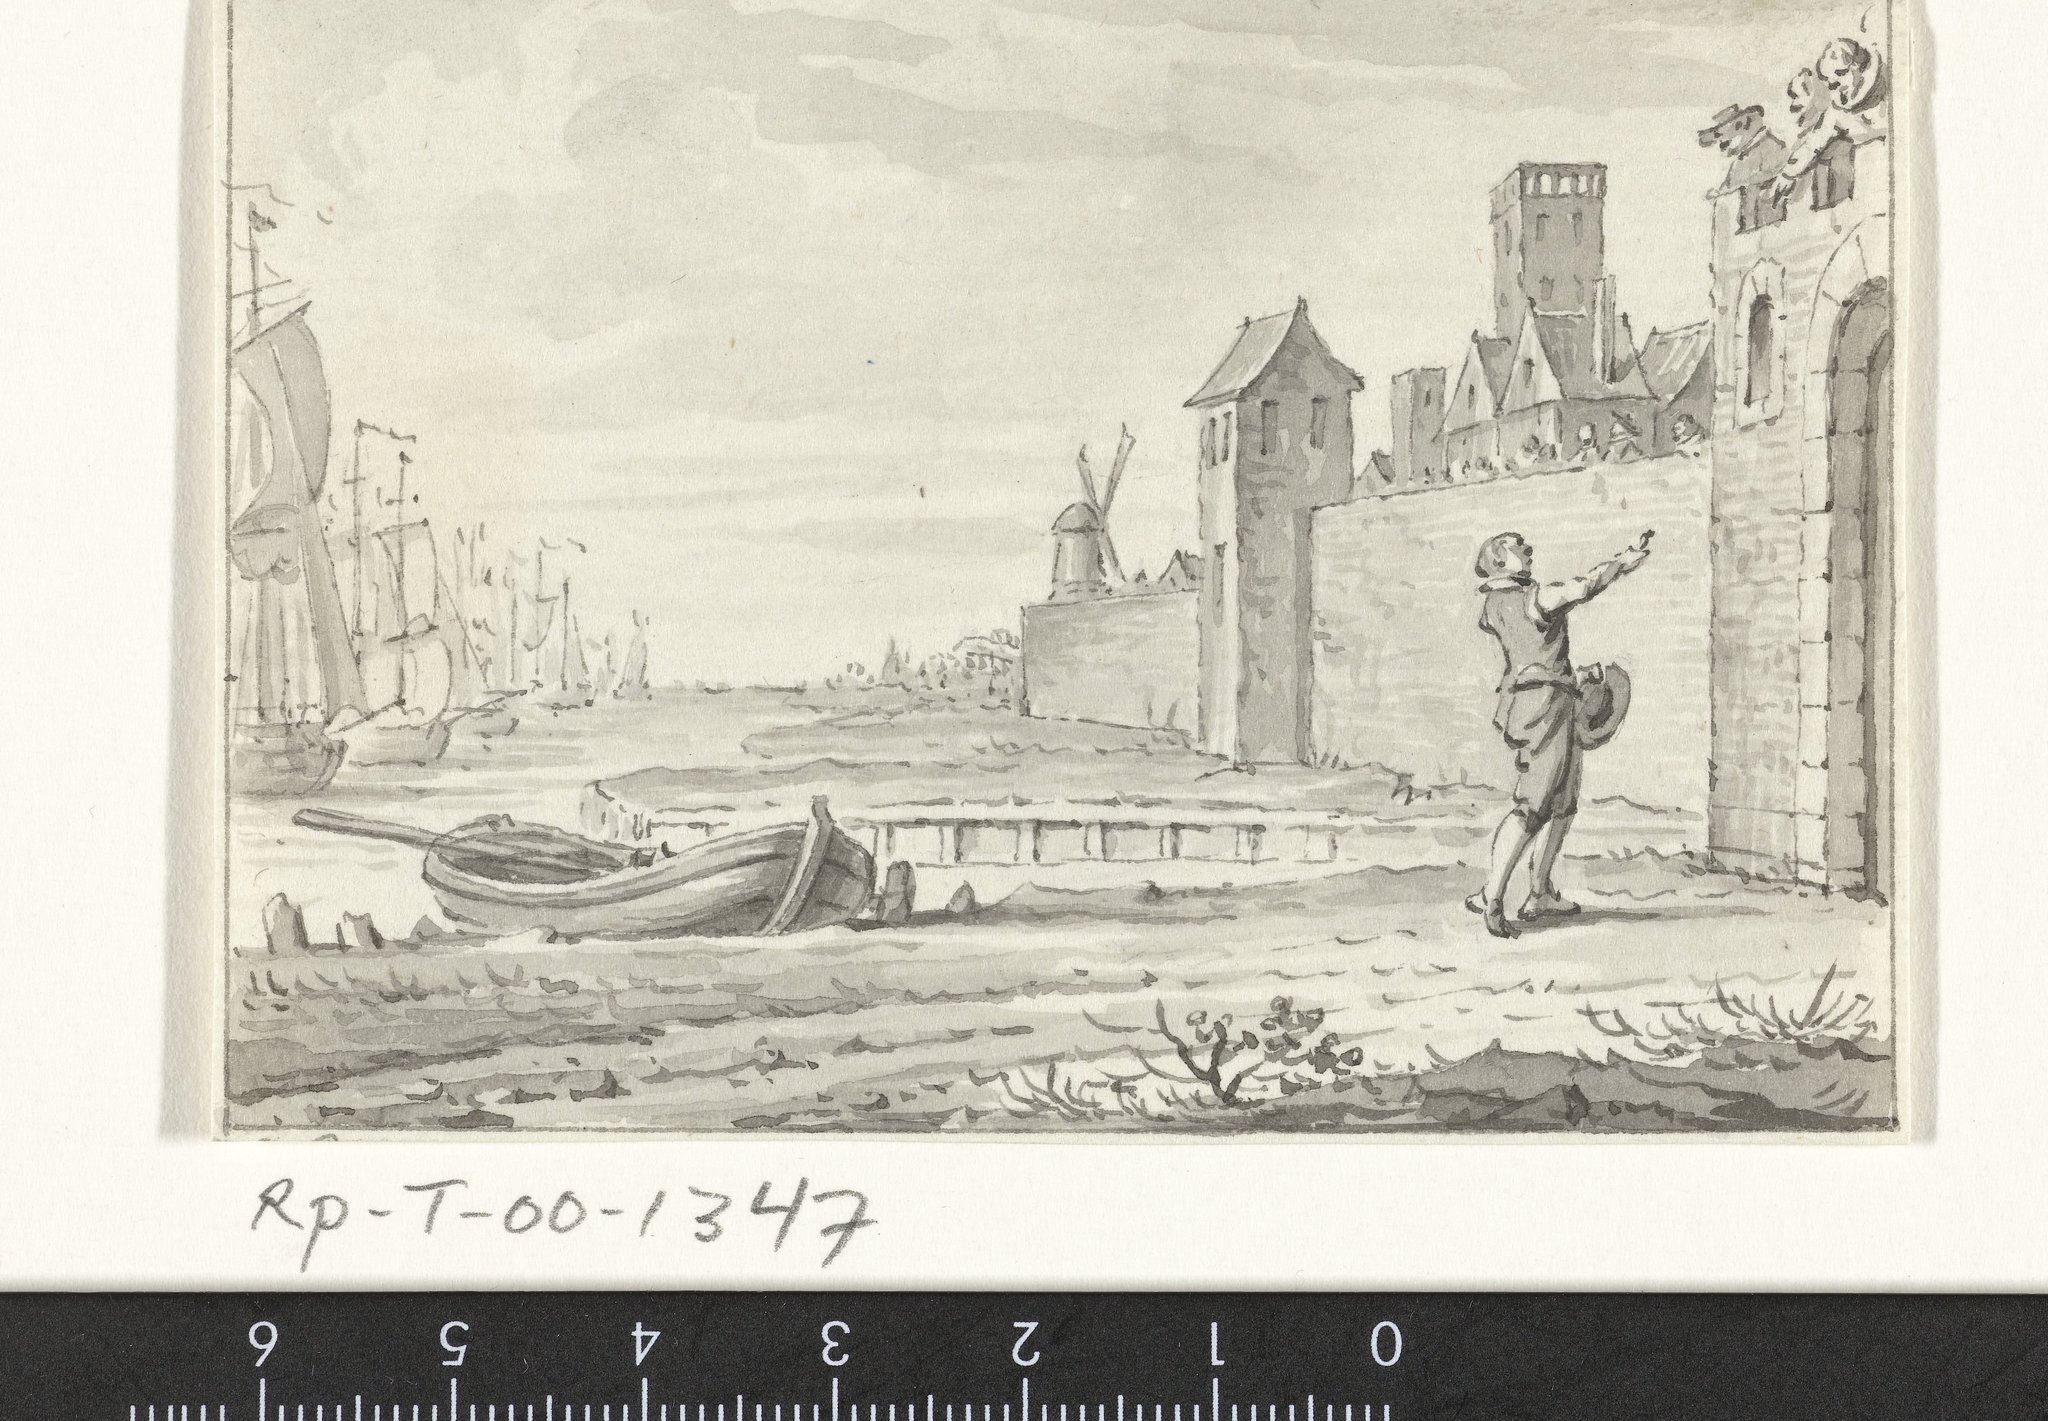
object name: design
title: De veerman Jan Pietersz. Koppelstok toont de ring van Treslong bij de onderhandelingen voor de stadsmuur van Den Briel, 1572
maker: jacobus buys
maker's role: draughtsman, print maker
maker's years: 1724-1801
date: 1785-1787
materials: ink, paper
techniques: brush, pen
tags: historical persons, historical events and situations, brielle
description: De veerman Koppelstok onderhandelt namens de watergeuzen van Lumey bij de stadspoort van den Briel, 1 april 1572. Ontwerp voor een prent.